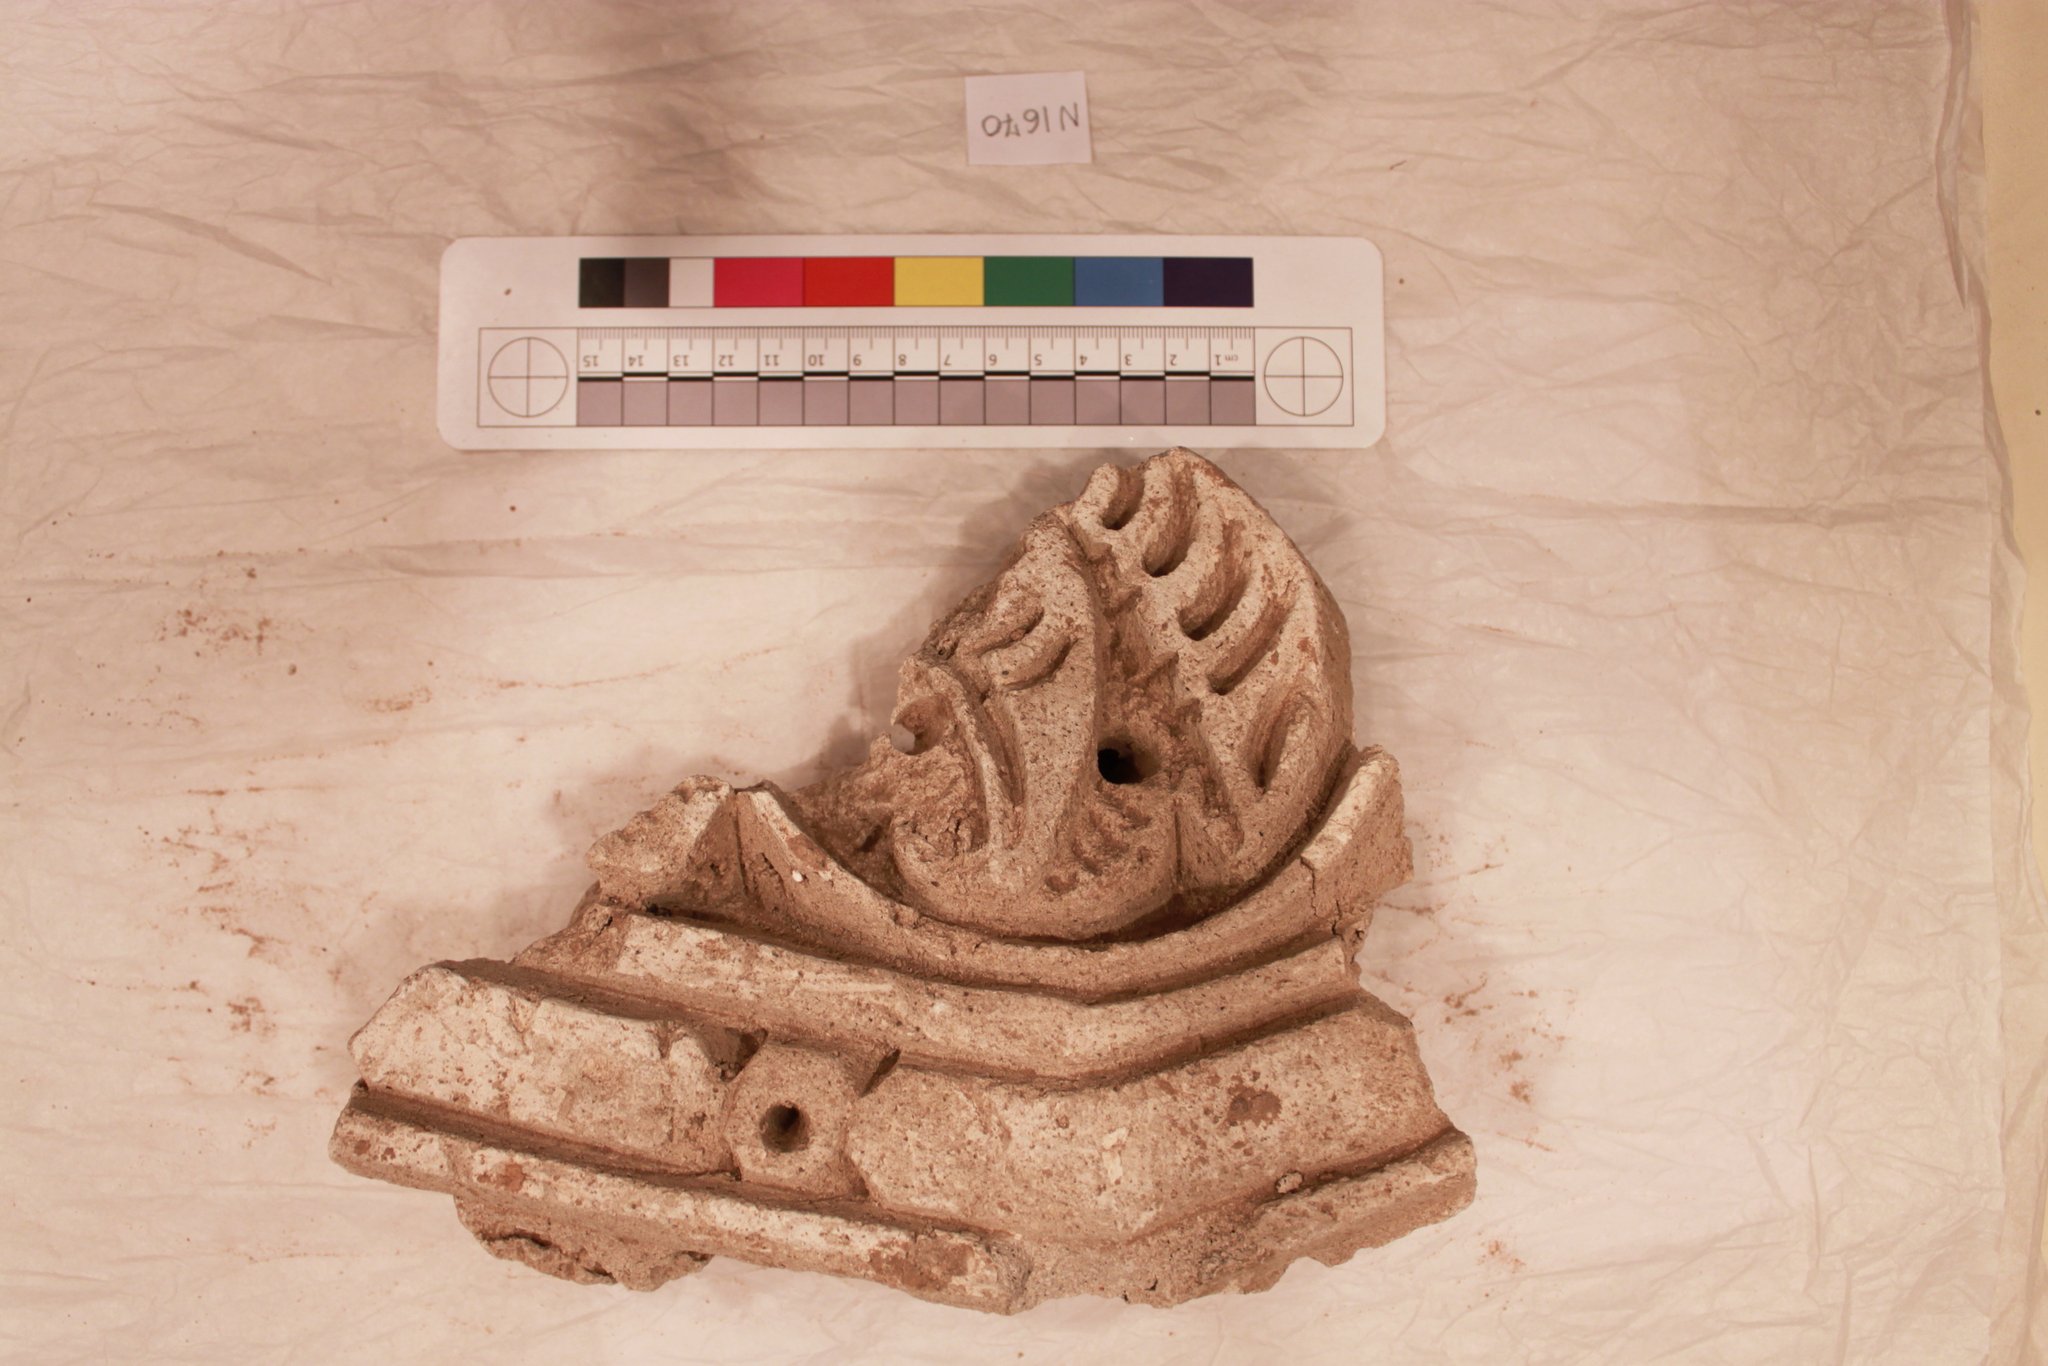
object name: fragment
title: Stucco Fragment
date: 701-1200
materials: plaster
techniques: carving, painting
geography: iran